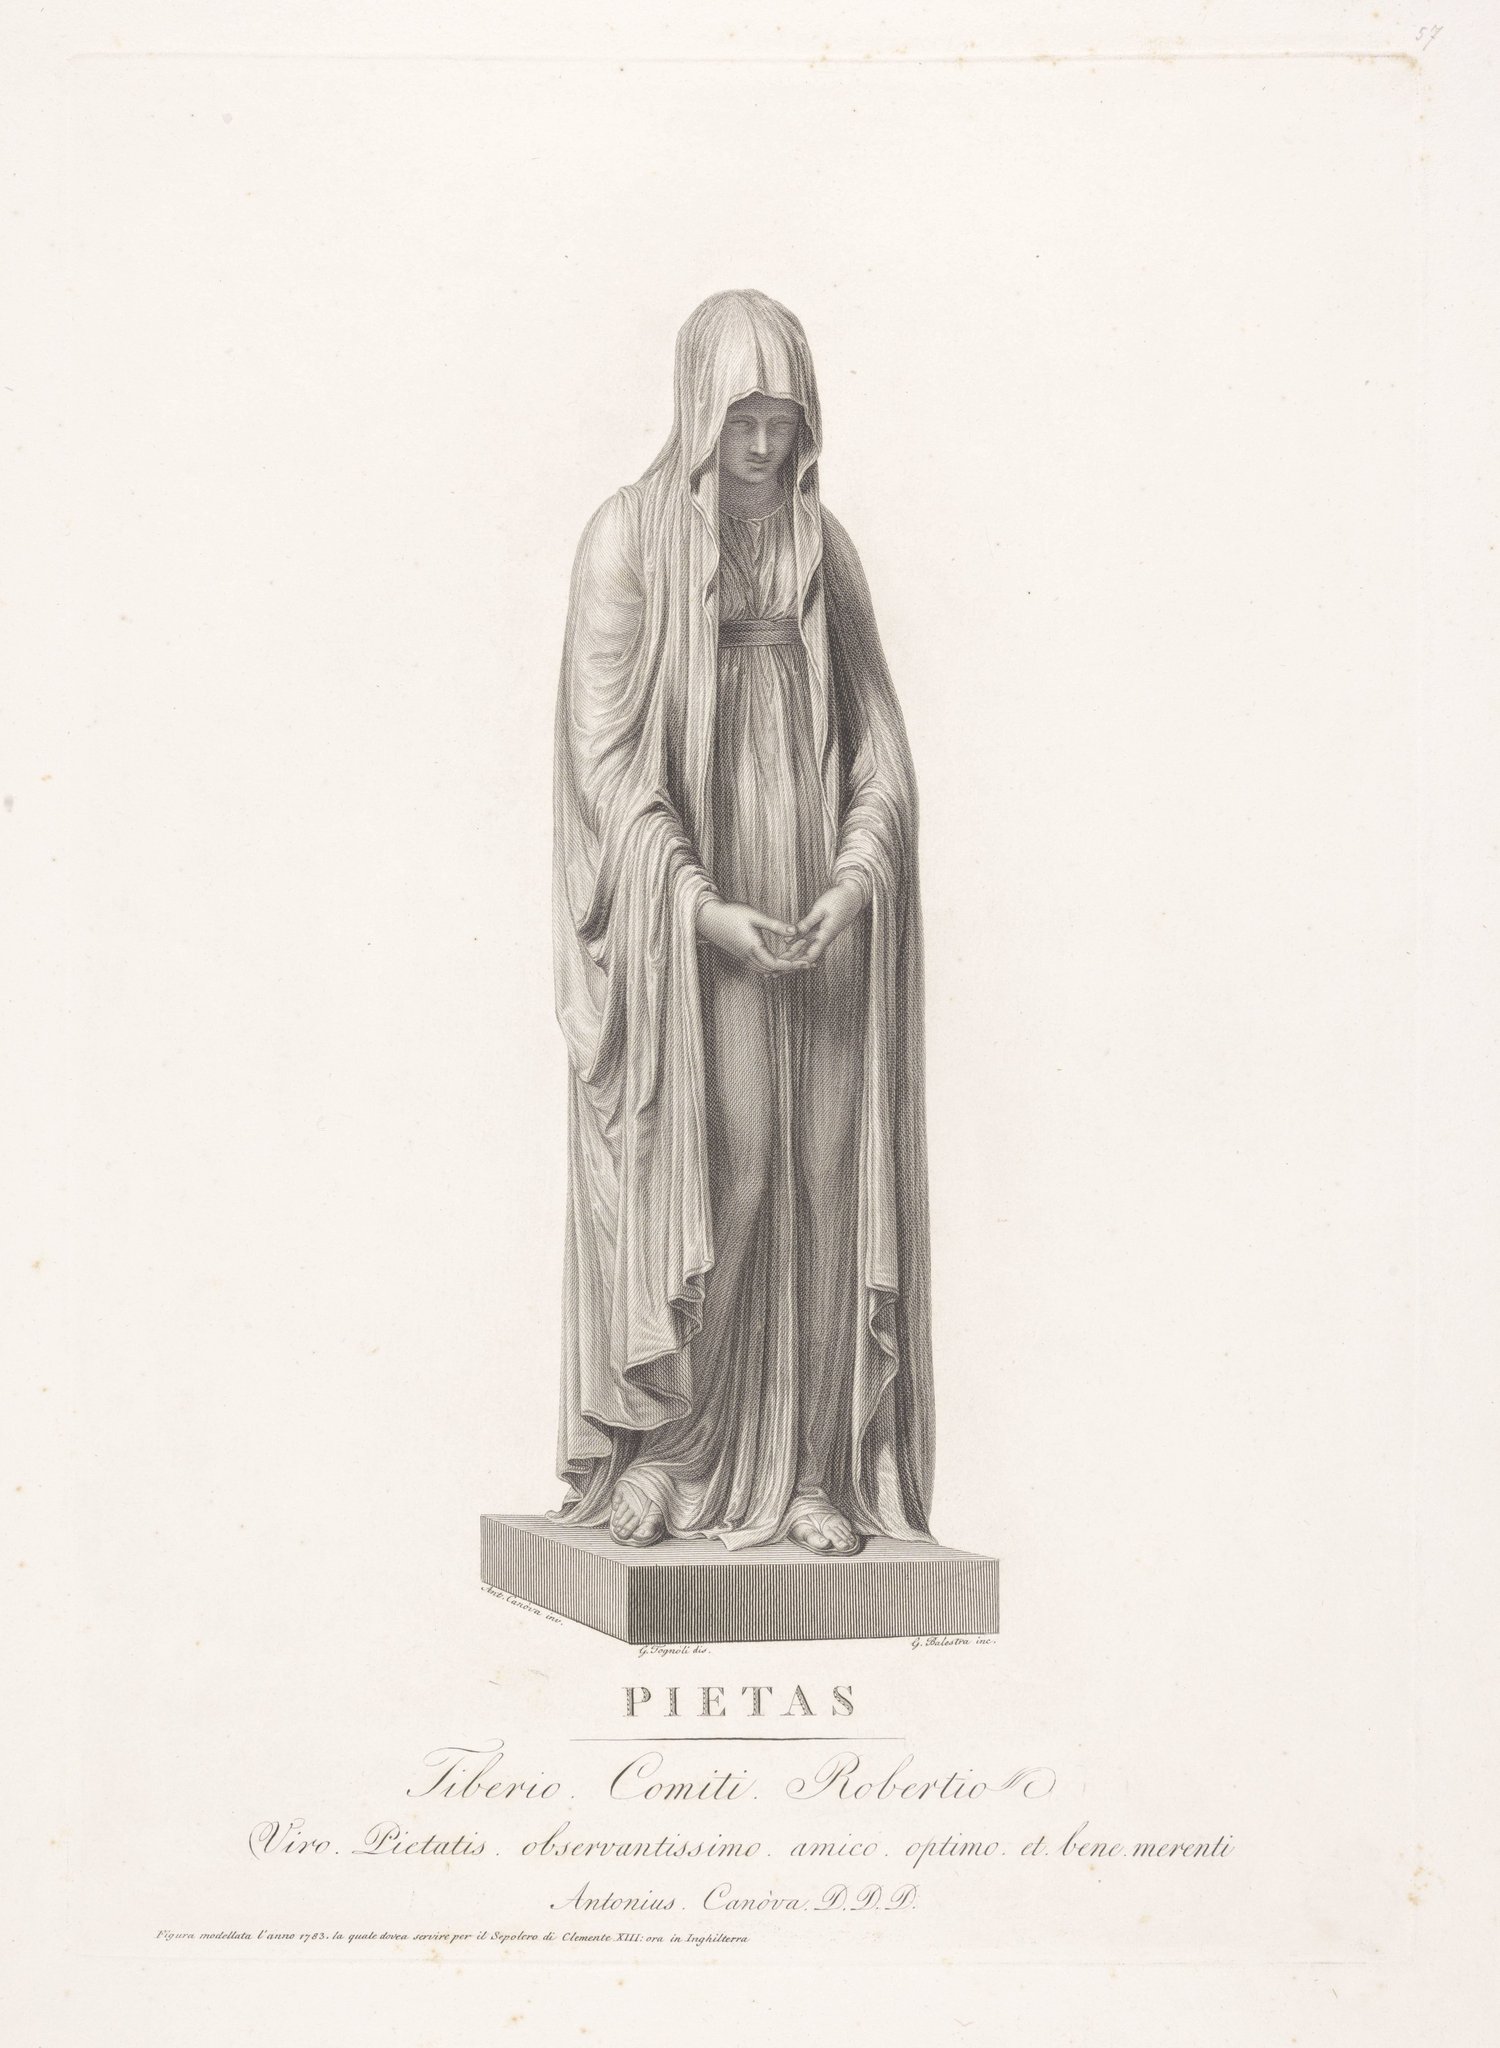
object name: print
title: Sculpturen van Antonio Canova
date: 1784-1842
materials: paper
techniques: engraving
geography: italy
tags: pietas as roman personification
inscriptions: collector's mark: Lugt 12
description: Deze prent maakt deel uit van een reeks van onbekende omvang met voorstellingen van sculpturen van Antonio Canova door verschillende prentmakers naar tekeningen van Giovanni Tognolli.